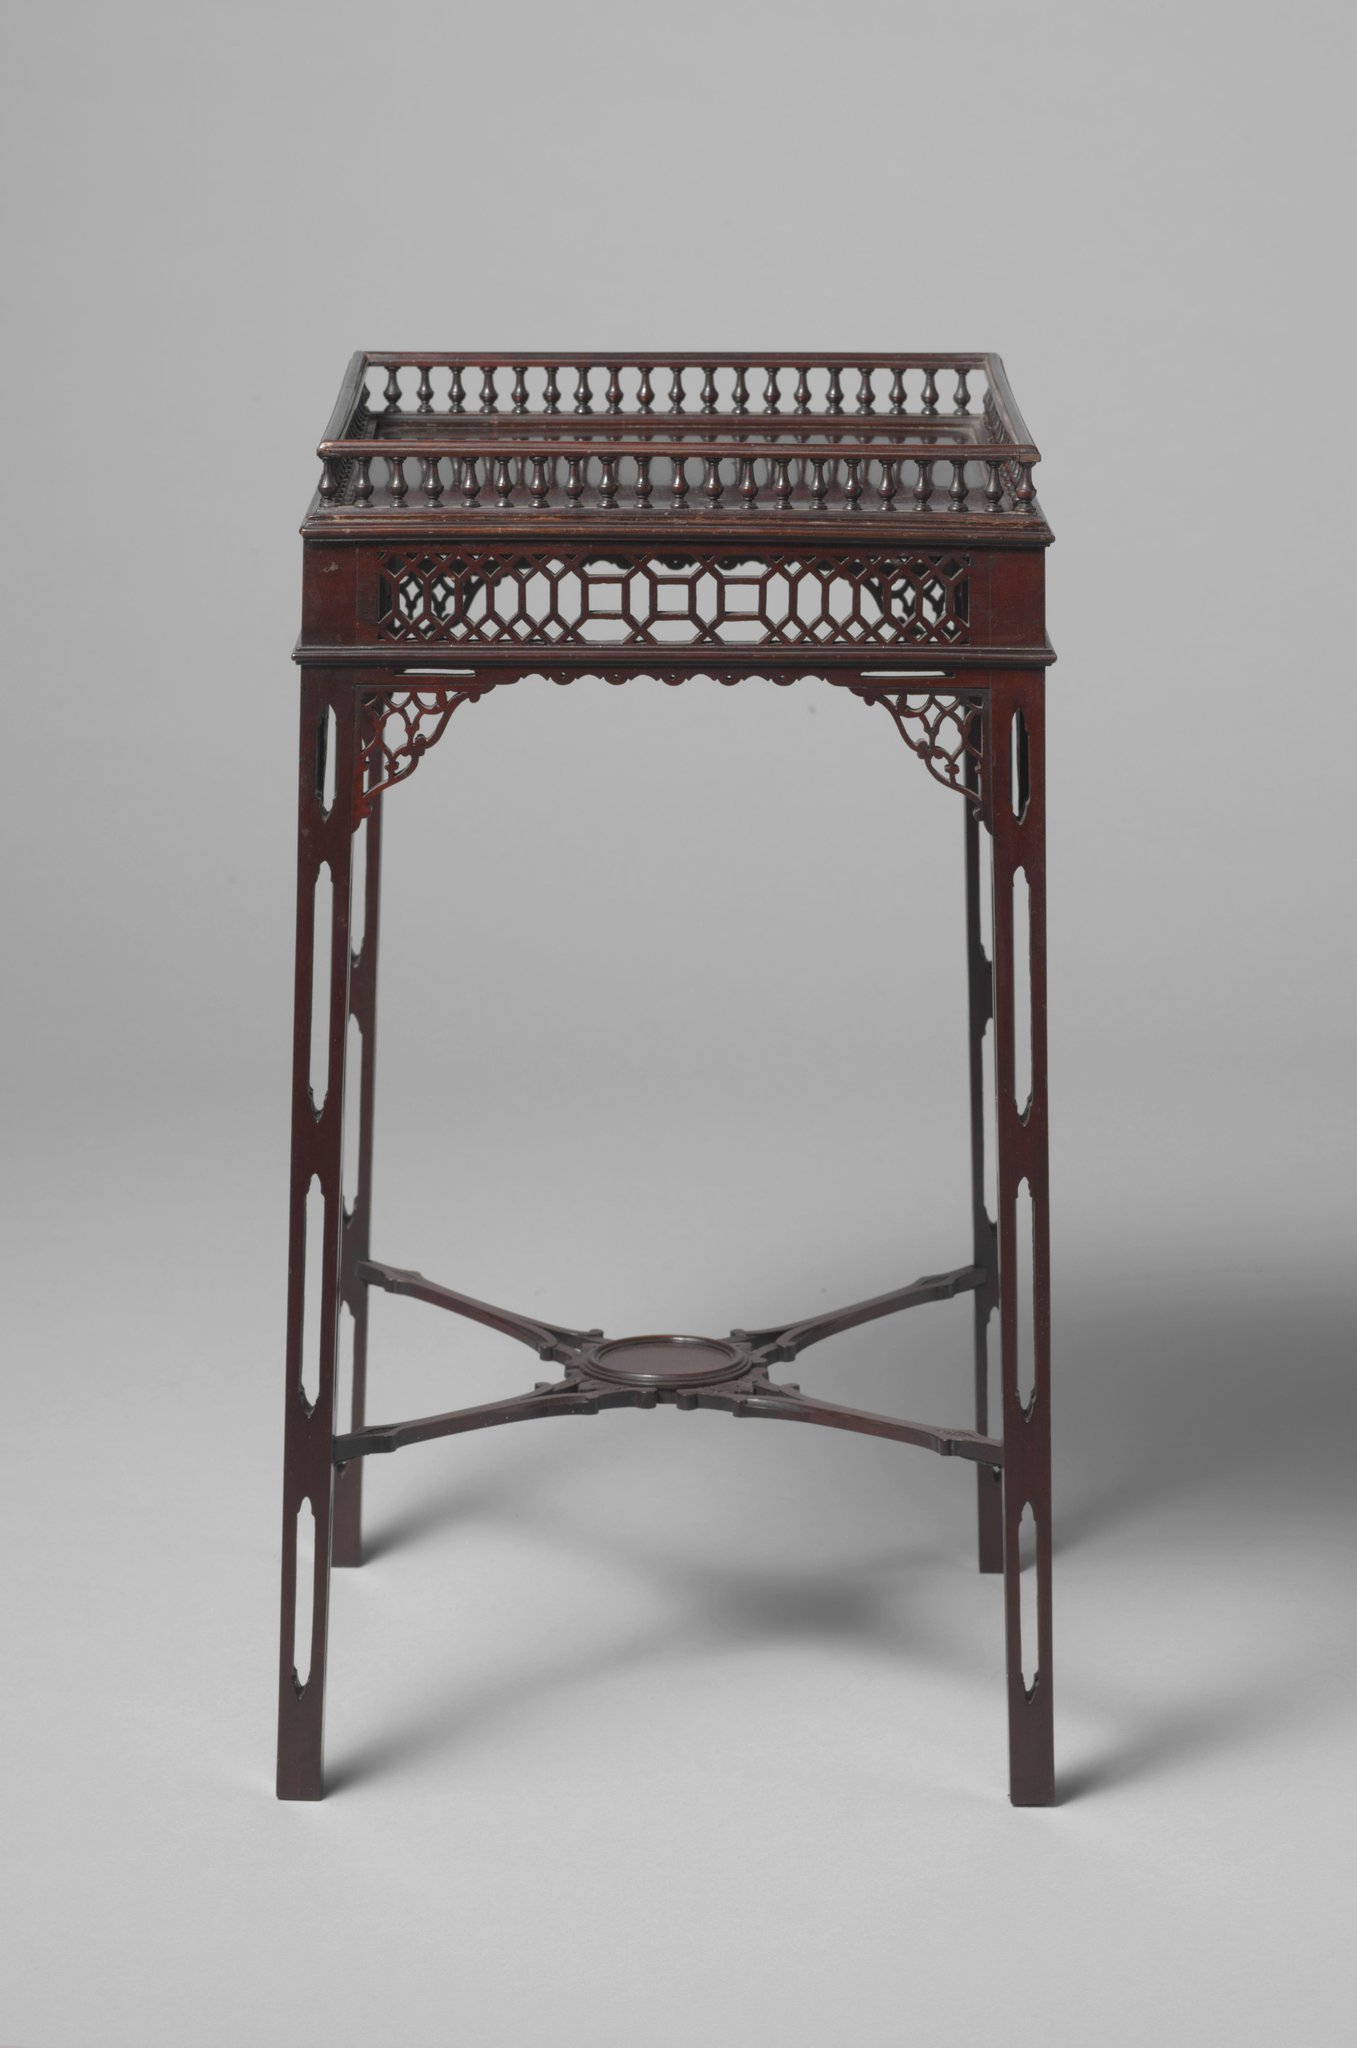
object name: furniture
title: Tafel, versierd in Chinese Chippendalestijl en voorzien van een dekplaat van glas.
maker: Anonymous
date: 1890-1910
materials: glass, wood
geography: great britain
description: Twee tafeltjes van mahoniehout, rustend op vier opengewerkte poten. De regels zijn eveneens opengewerkt. De tafels zijn in Chinese Chippendale stijl gedecoreerd en voorzien van glazen dekplaten.